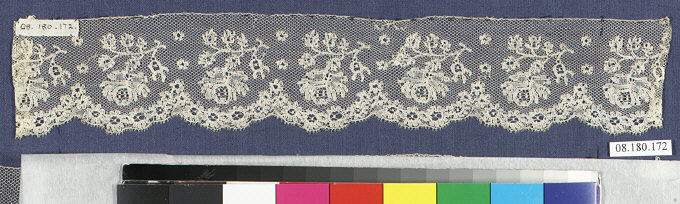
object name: fragment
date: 1801-1900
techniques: lace